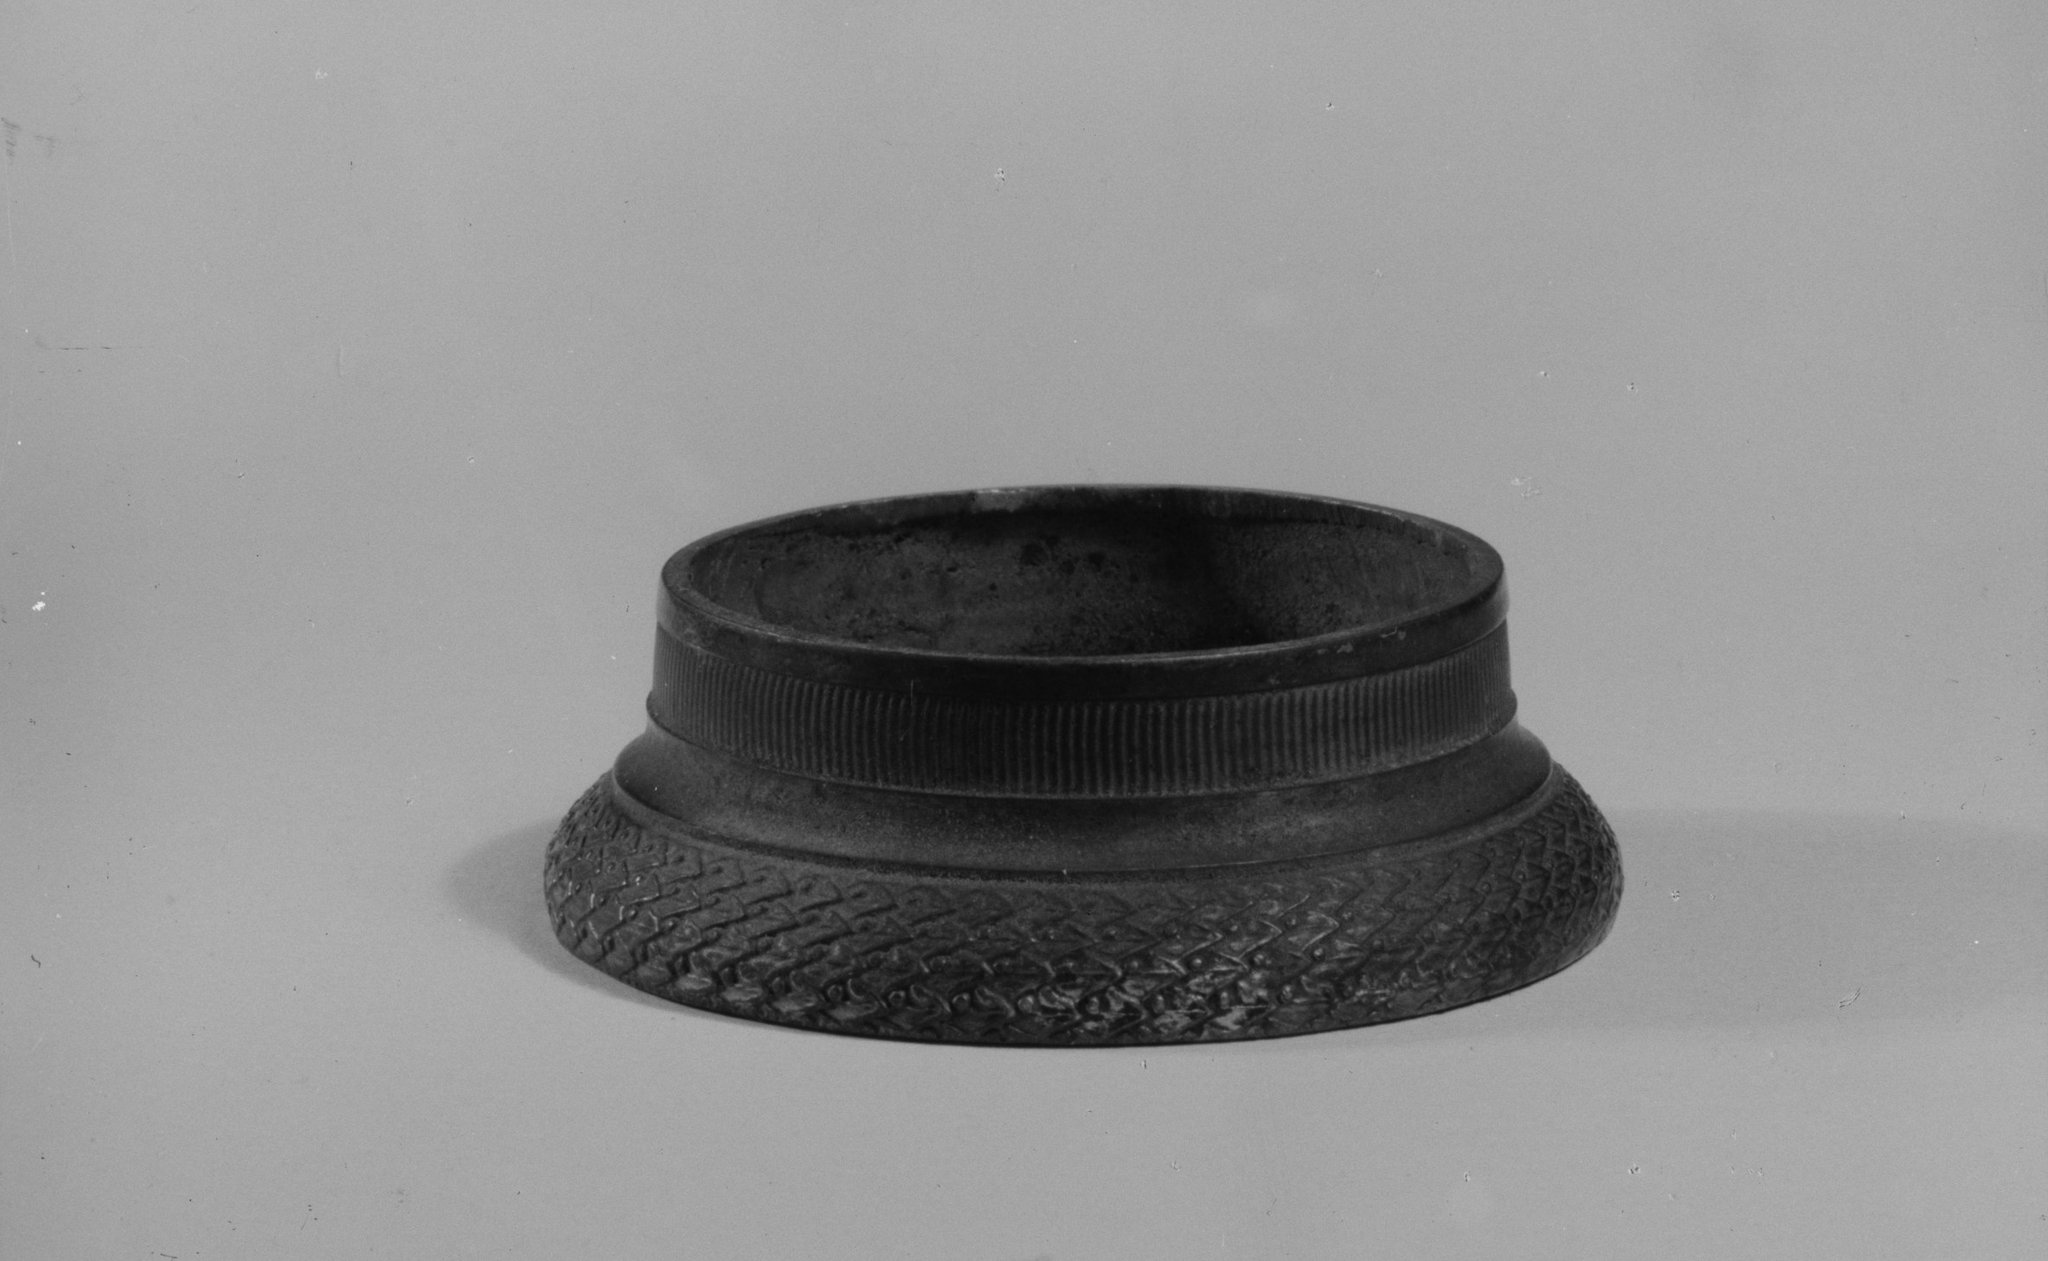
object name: cap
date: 1820-1825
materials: brass